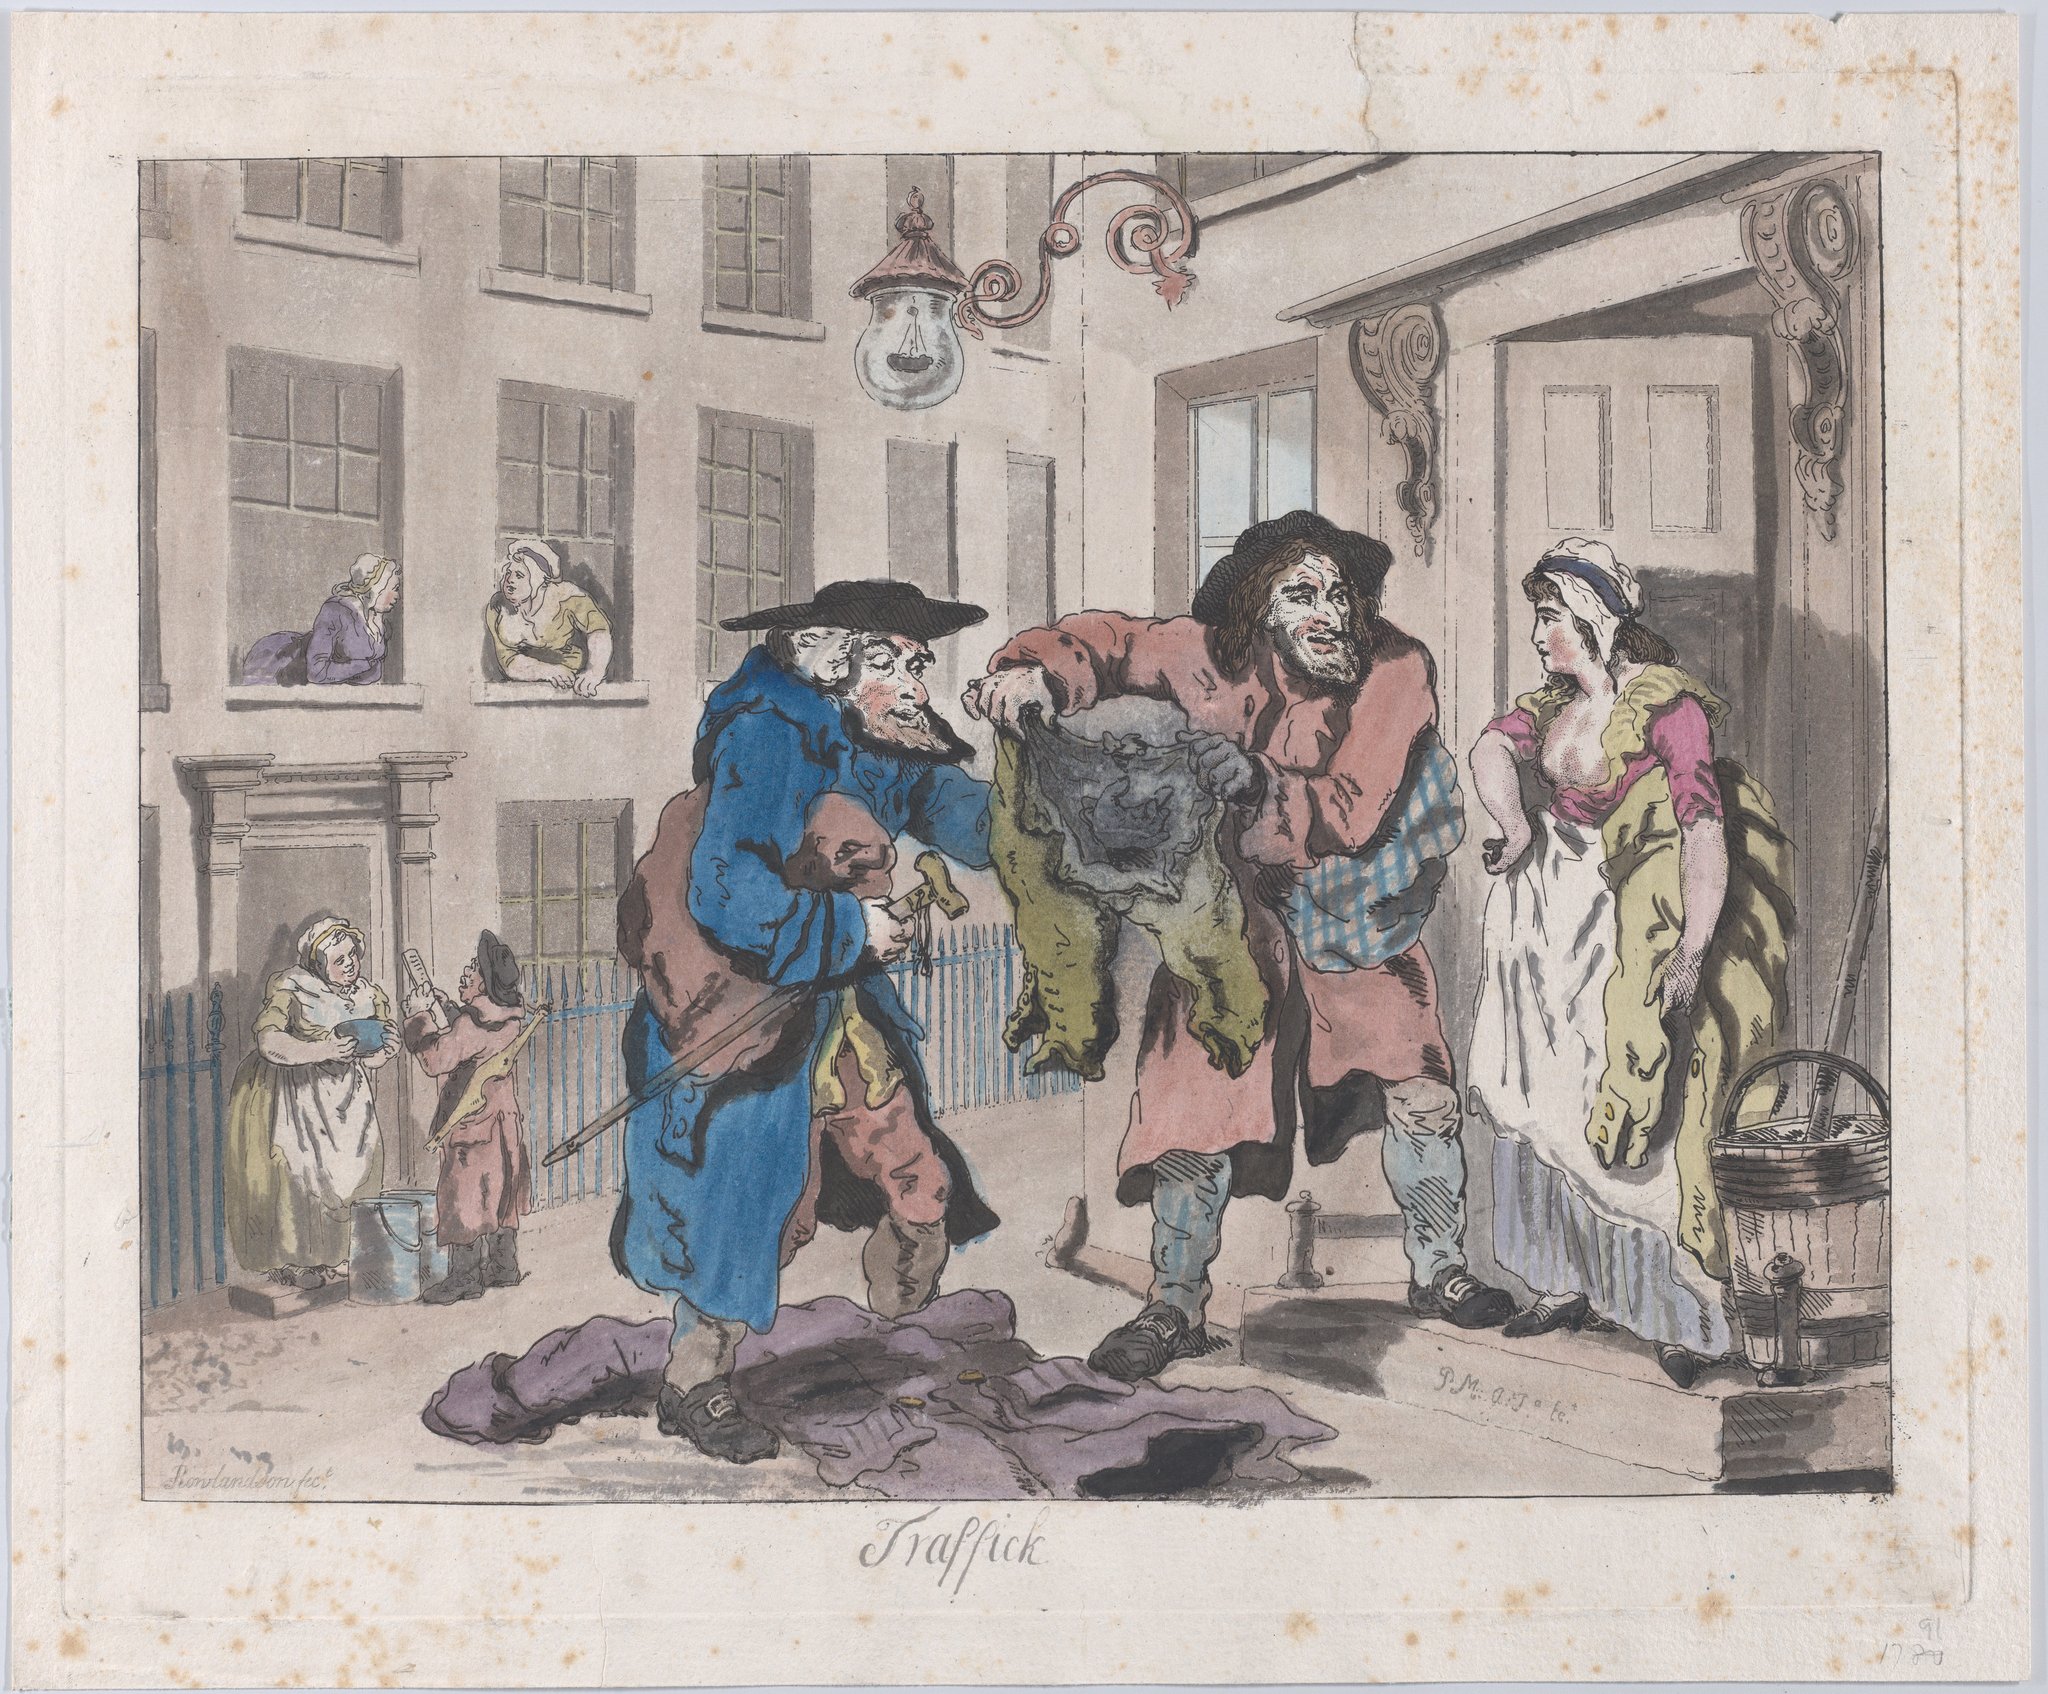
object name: print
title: Traffic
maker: thomas rowlandson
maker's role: artist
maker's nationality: british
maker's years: 1757-1827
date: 1791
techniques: aquatint, etching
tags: satire,men,women,servants